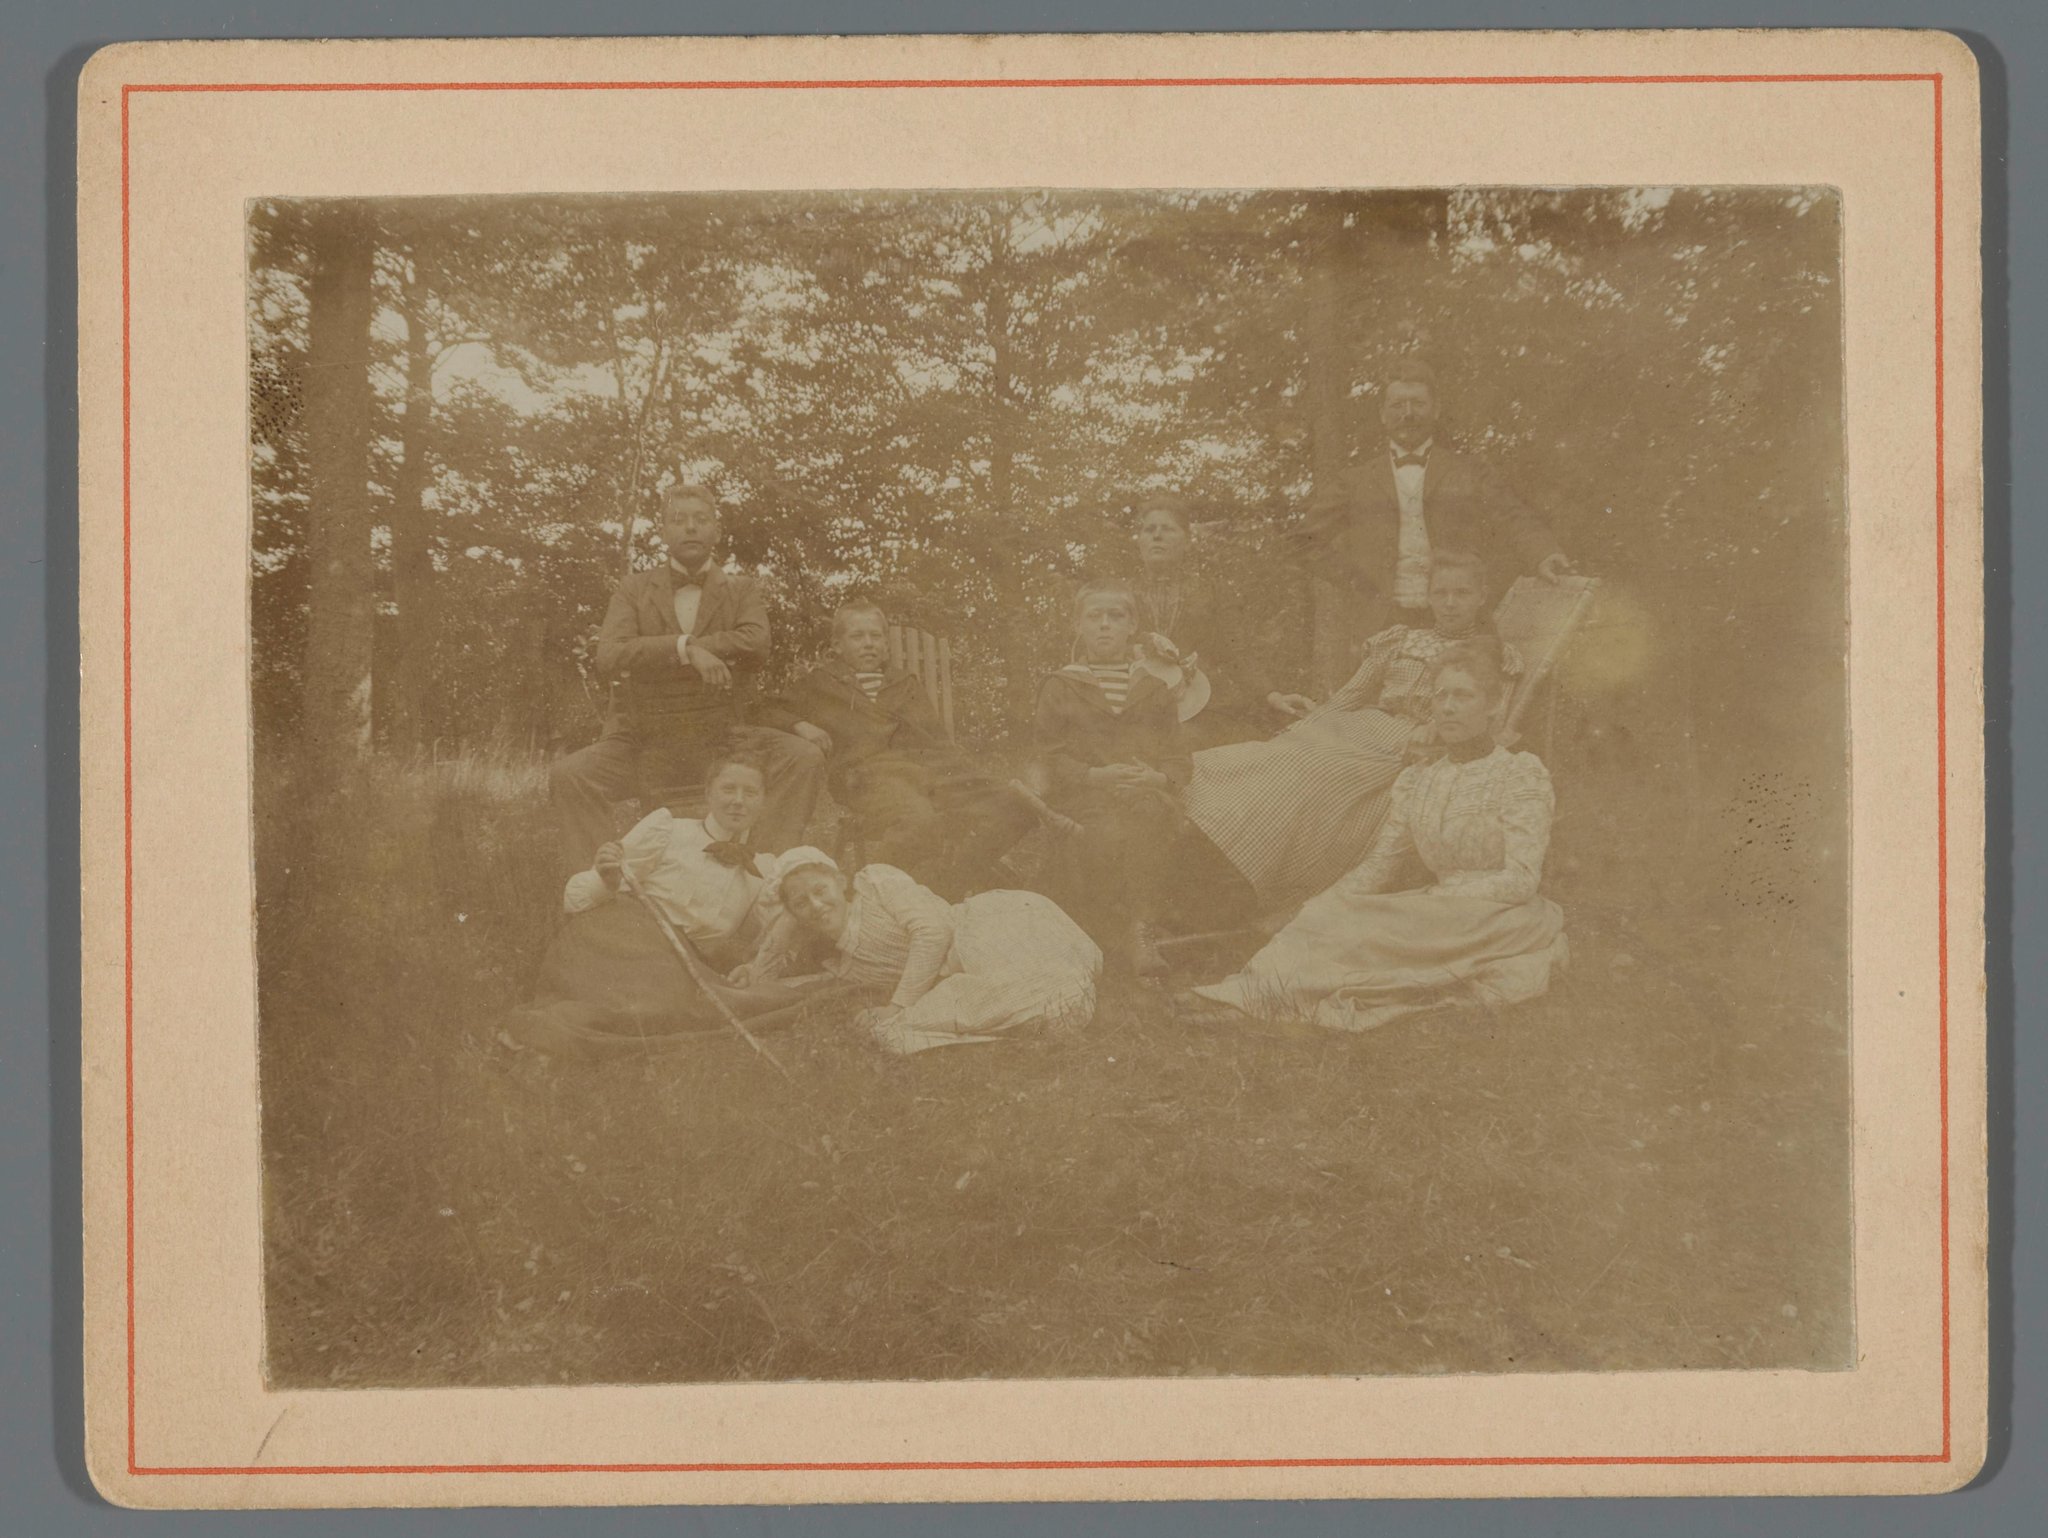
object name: photograph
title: Groepsportret in het gras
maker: cornelia hendrika jonker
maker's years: 1874-1924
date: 1899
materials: cardboard, photographic support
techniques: collodion silver print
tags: garden, anonymous historical persons portrayed in a group, in a group-portrait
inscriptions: annotation: ‘1899/ [...]’